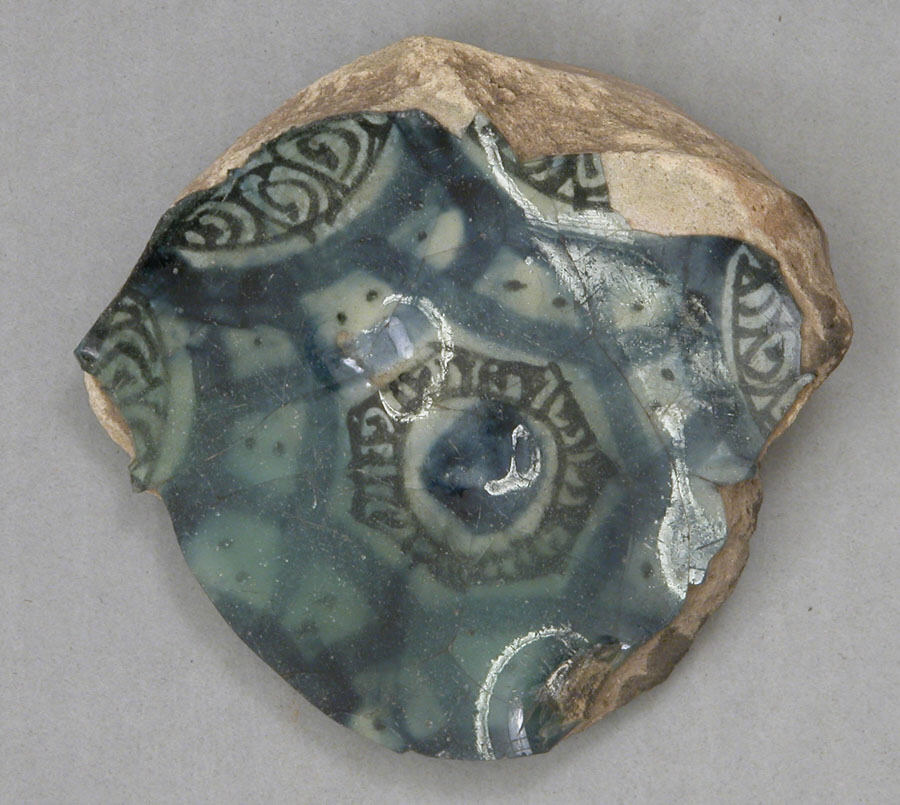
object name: ceramic fragment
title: Fragment of a Dish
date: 1301-1500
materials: glaze, stonepaste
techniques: painting, polychrome, underglaze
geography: egypt